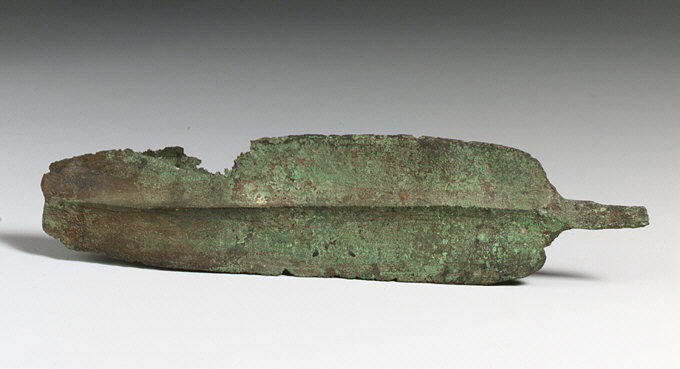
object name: dagger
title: Dagger blade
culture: cypriot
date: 3000-2000 BCE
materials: bronze